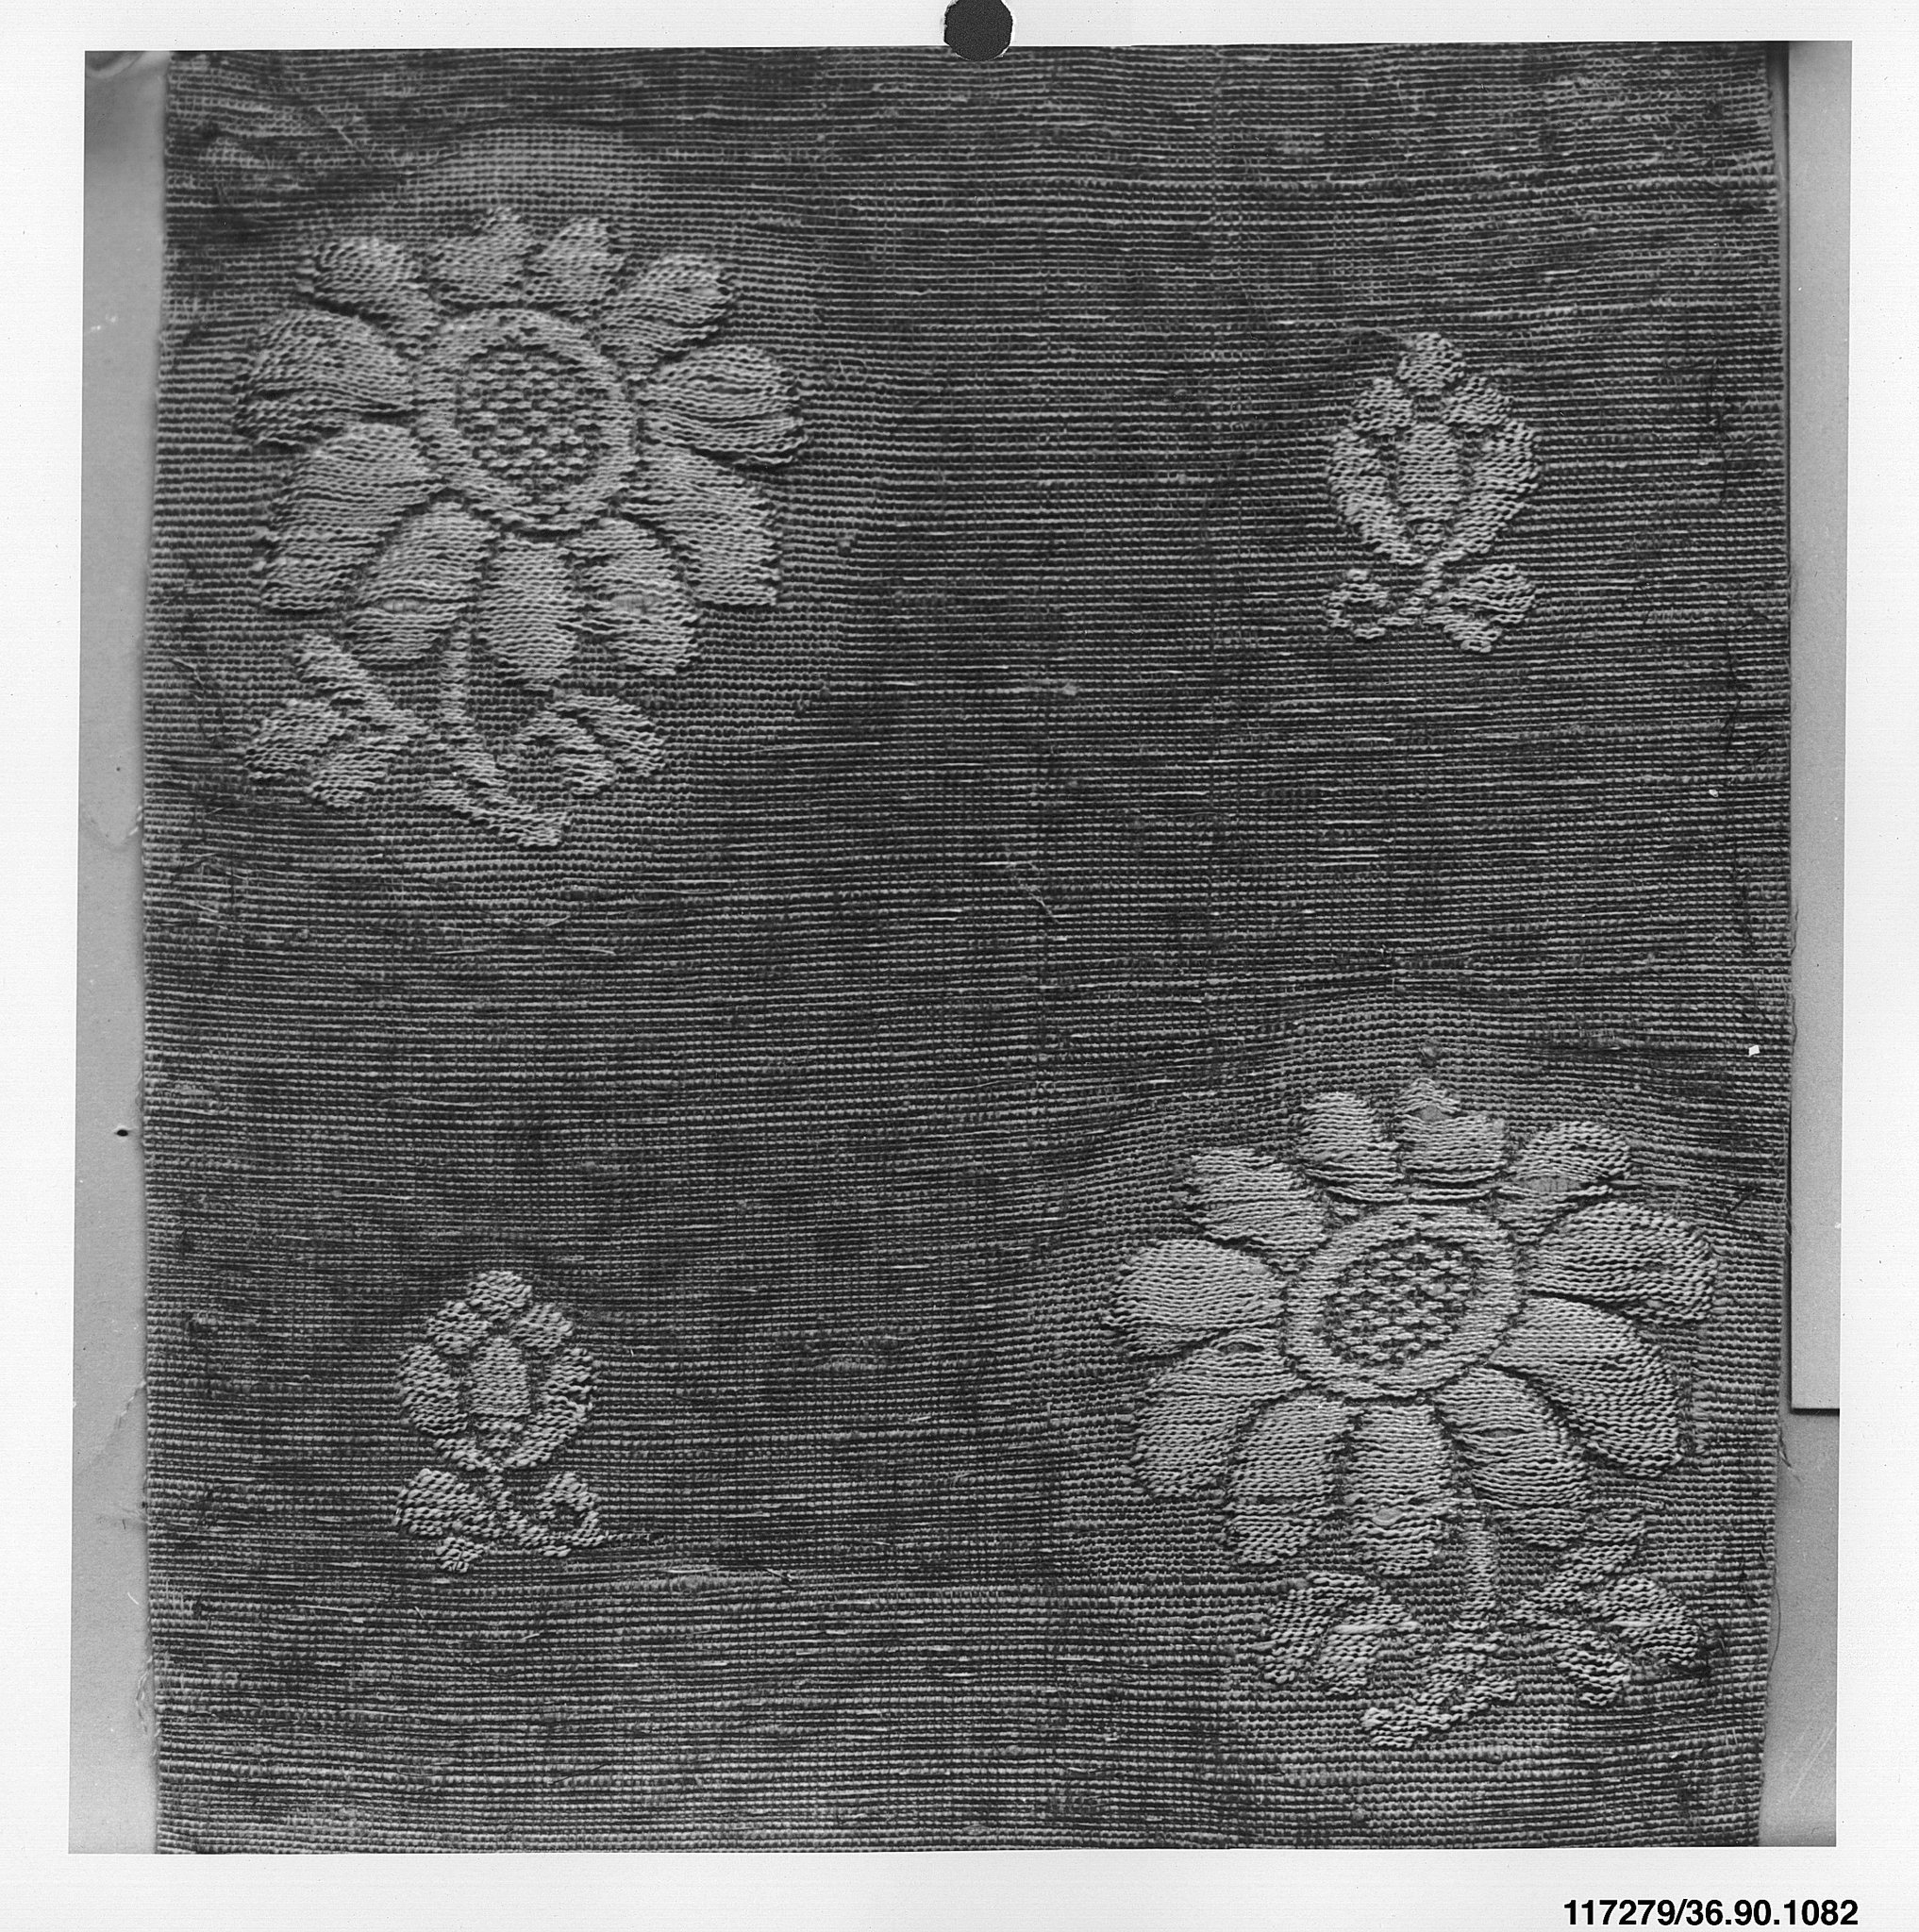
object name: piece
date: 1701-1900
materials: metal thread, silk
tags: flowers,leaves